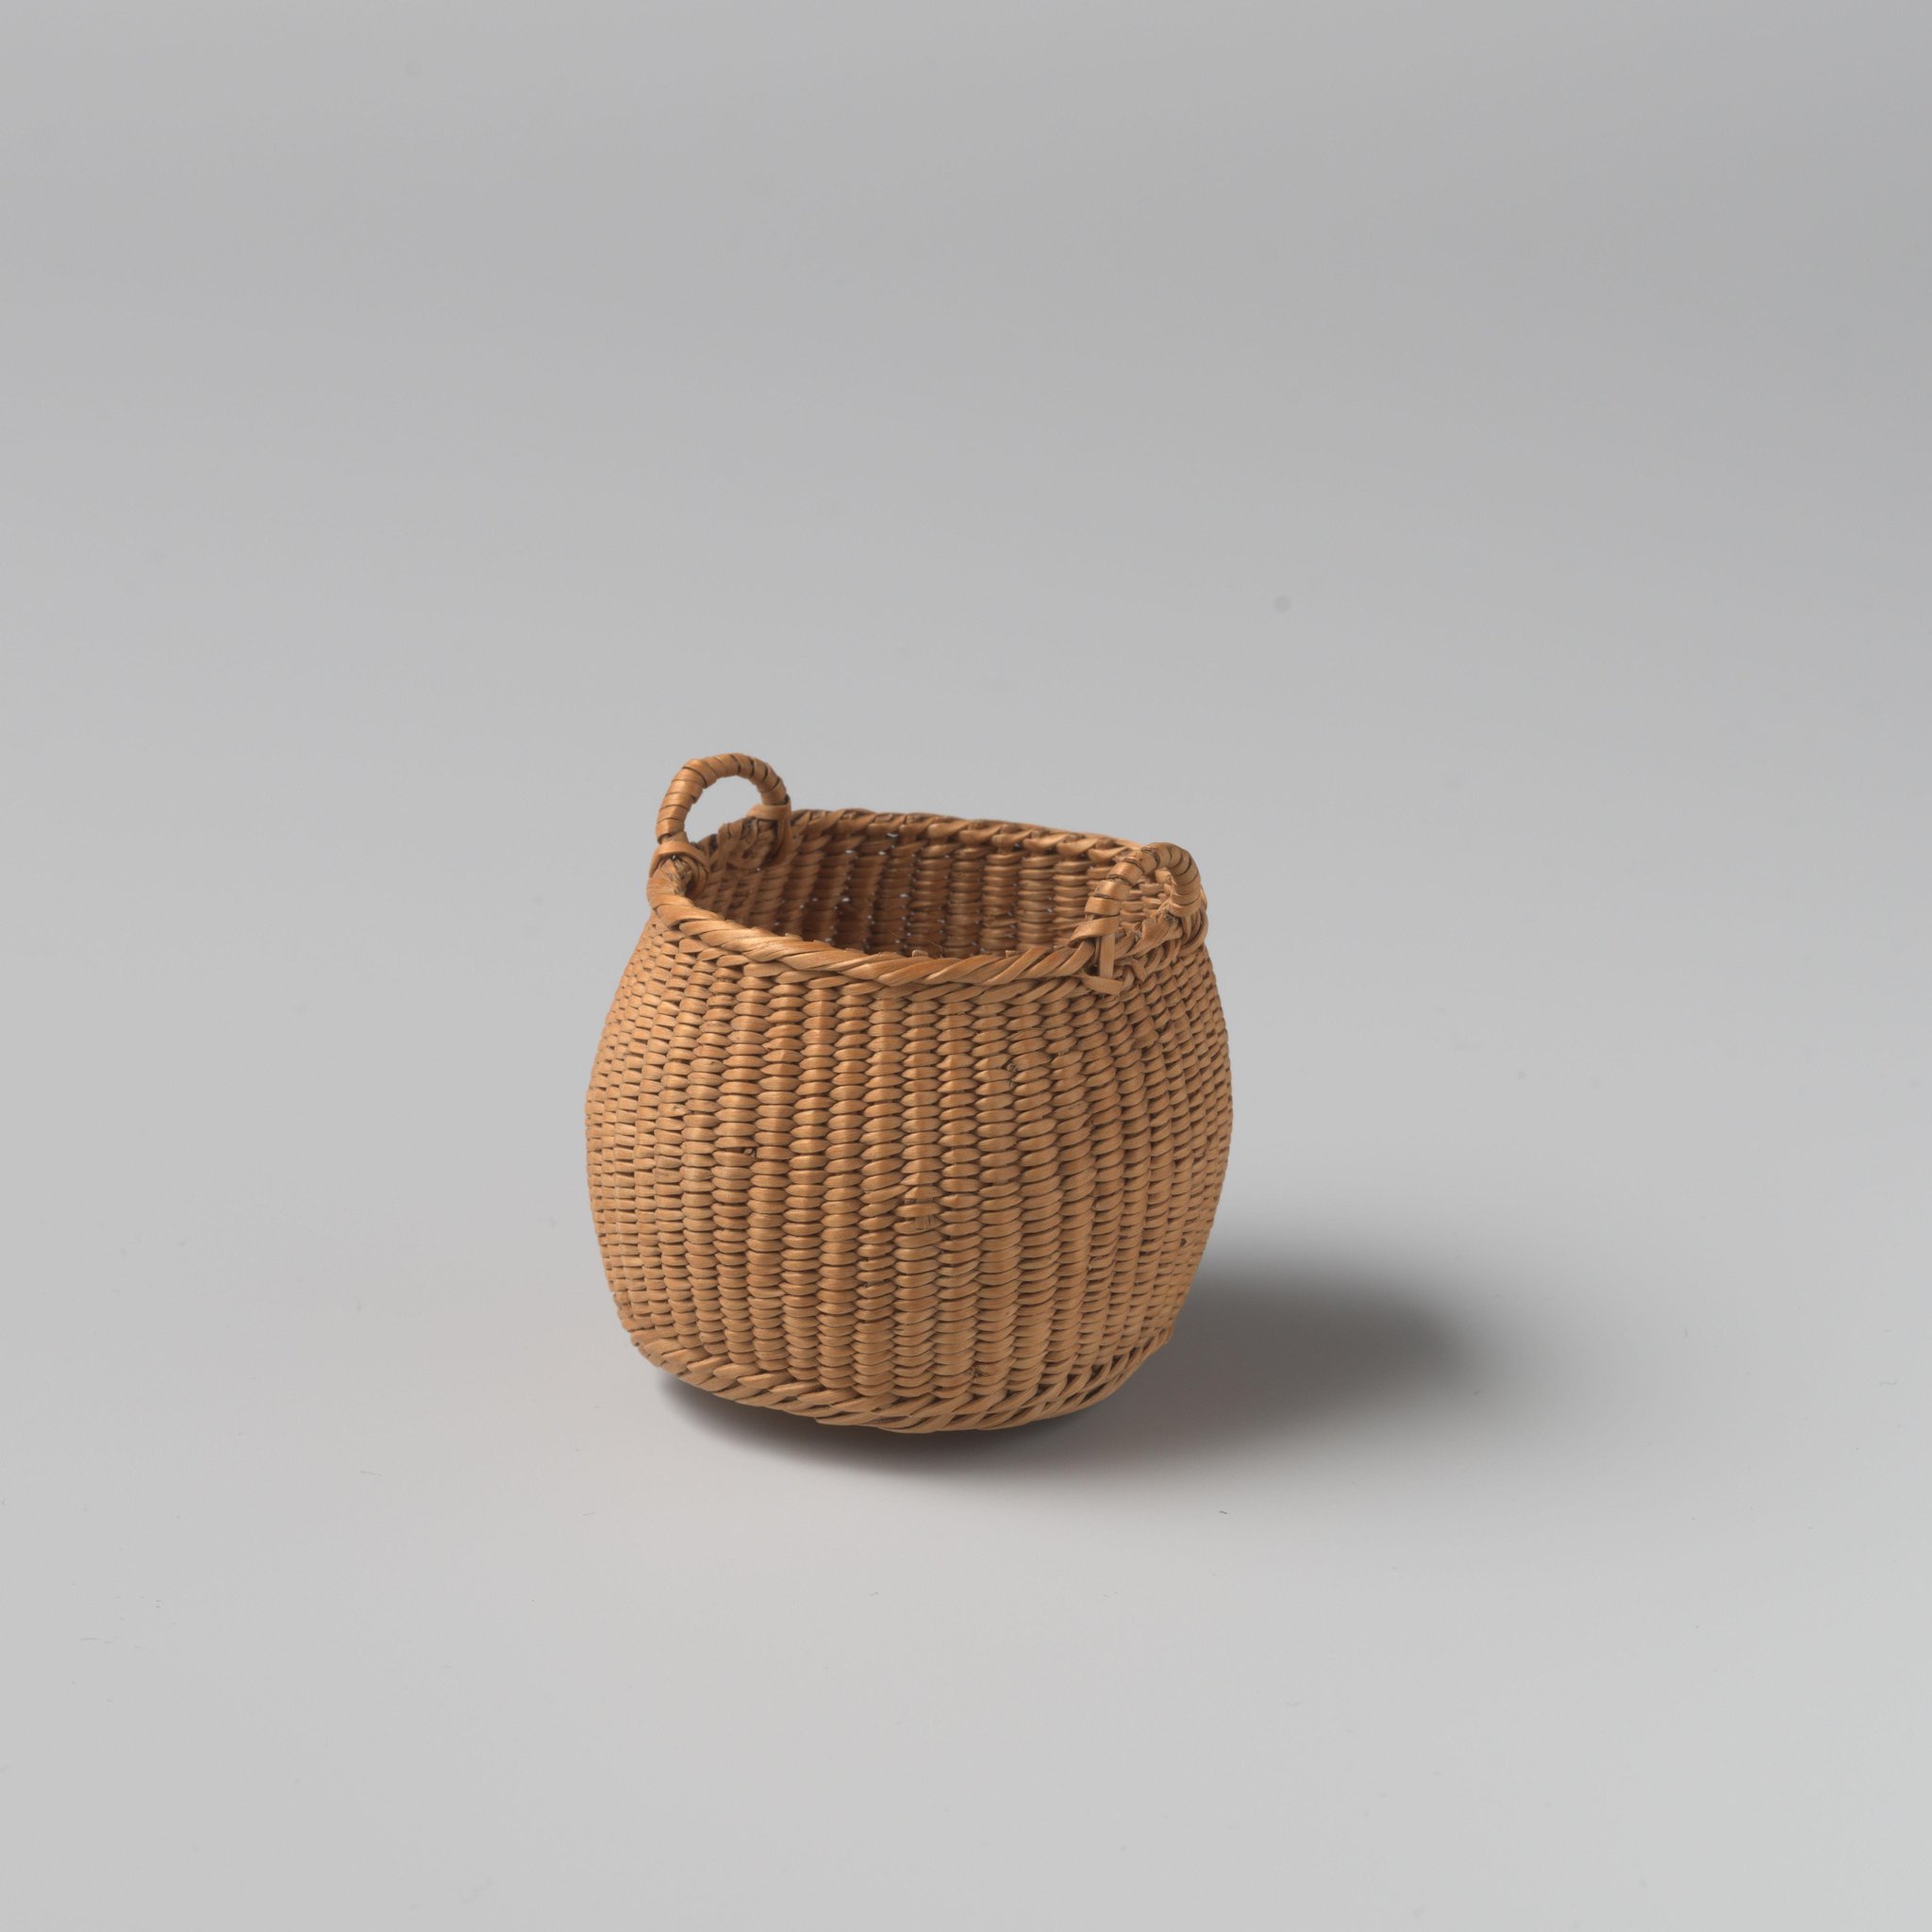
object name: miniature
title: Ronde mand van gespleten wilgenteen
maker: Anonymous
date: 1690-1710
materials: plant material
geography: halle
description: Ronde, bolle mand van gespleten wilgenteen, fijnscheenwerk. Bovenop de rand twee handvatten.